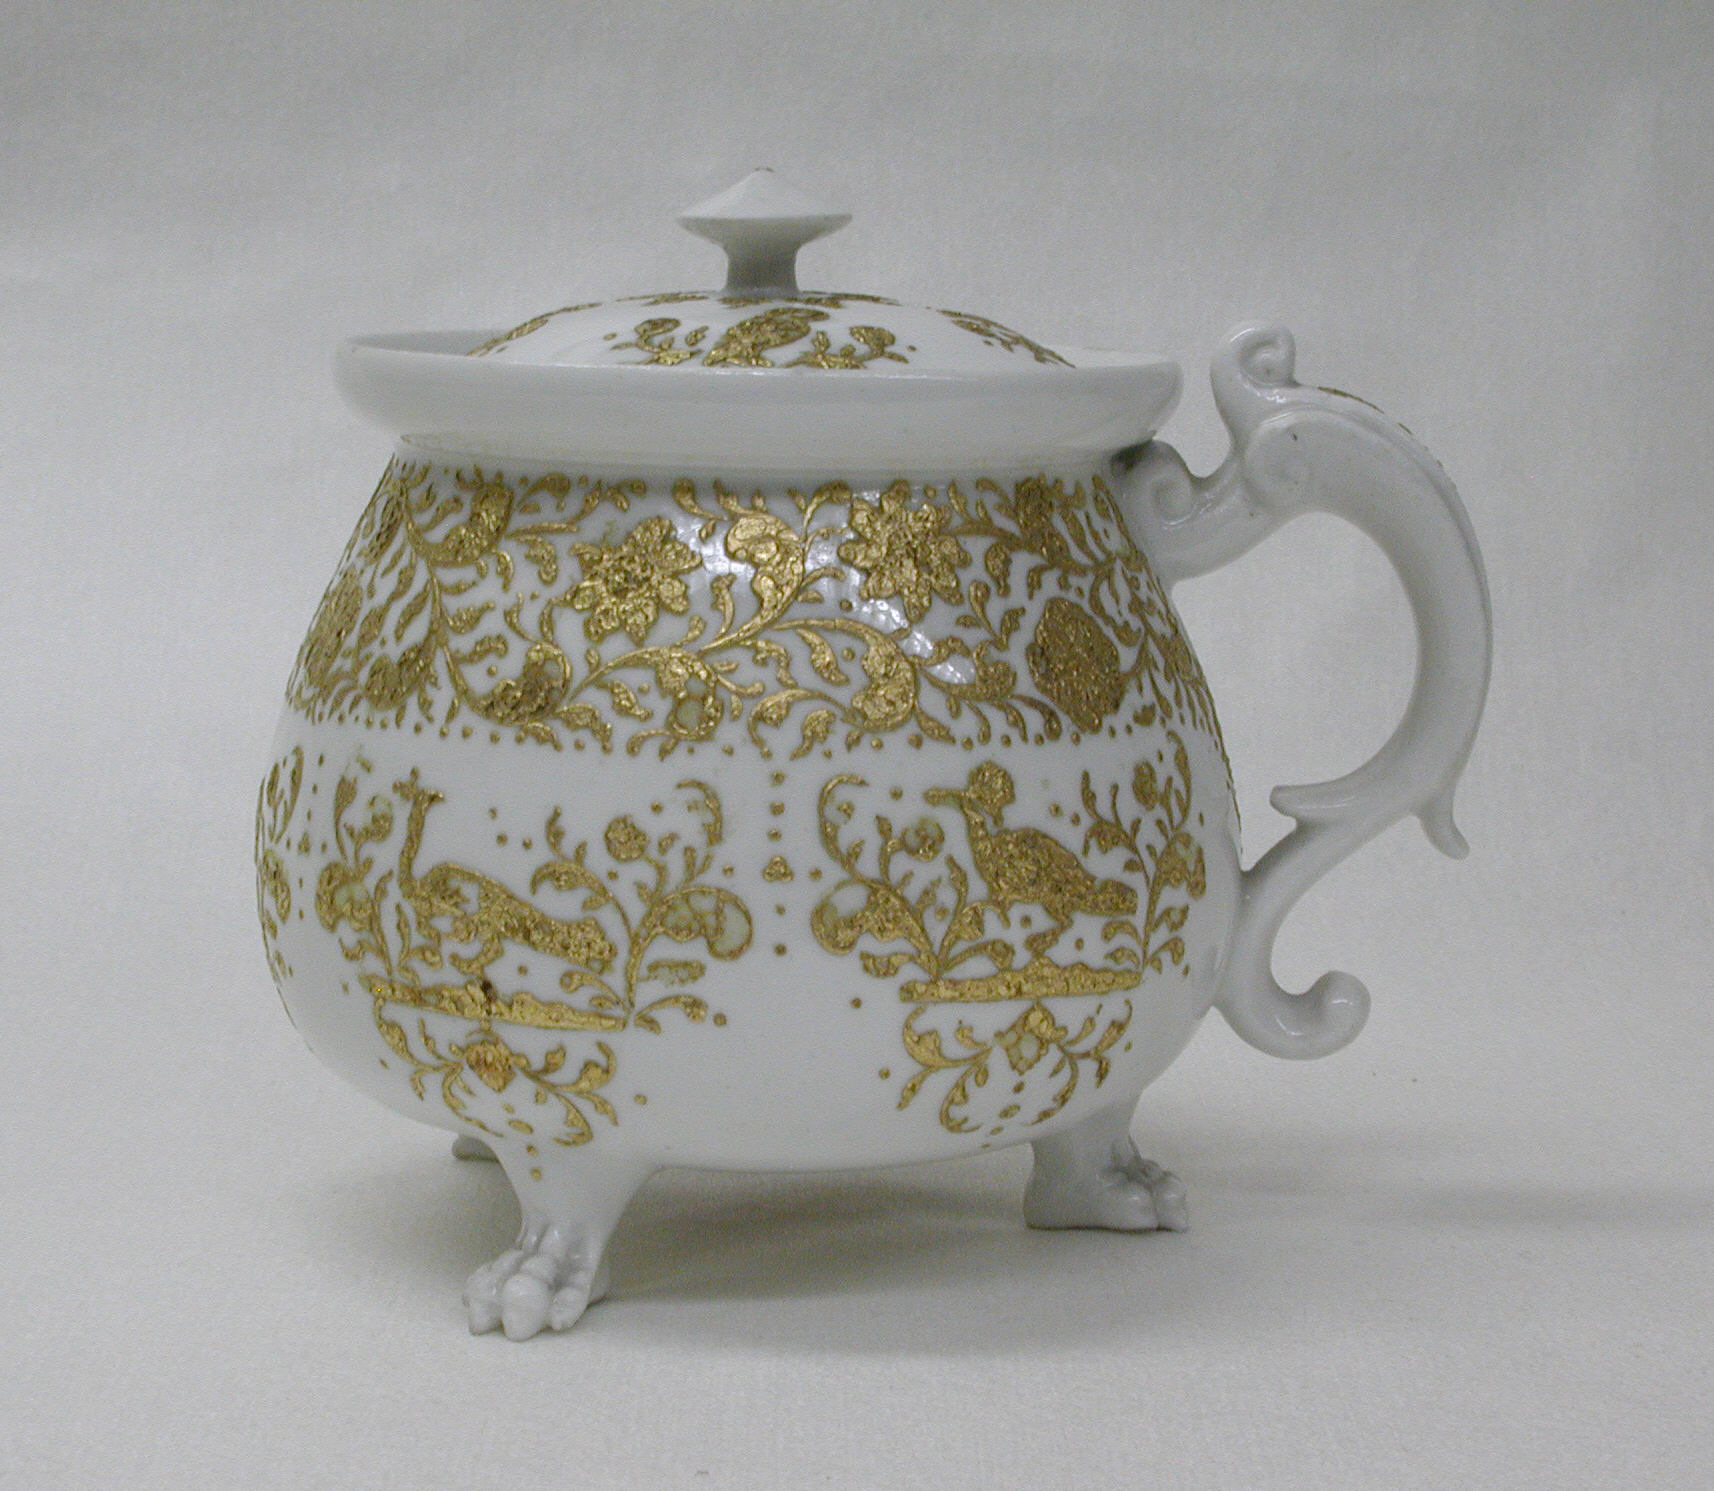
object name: sugar bowl with cover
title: Sugar bowl with cover (part of a service)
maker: meissen manufactory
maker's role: manufactory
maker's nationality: german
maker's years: 1710-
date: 1720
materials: hard paste porcelain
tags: birds,flowers